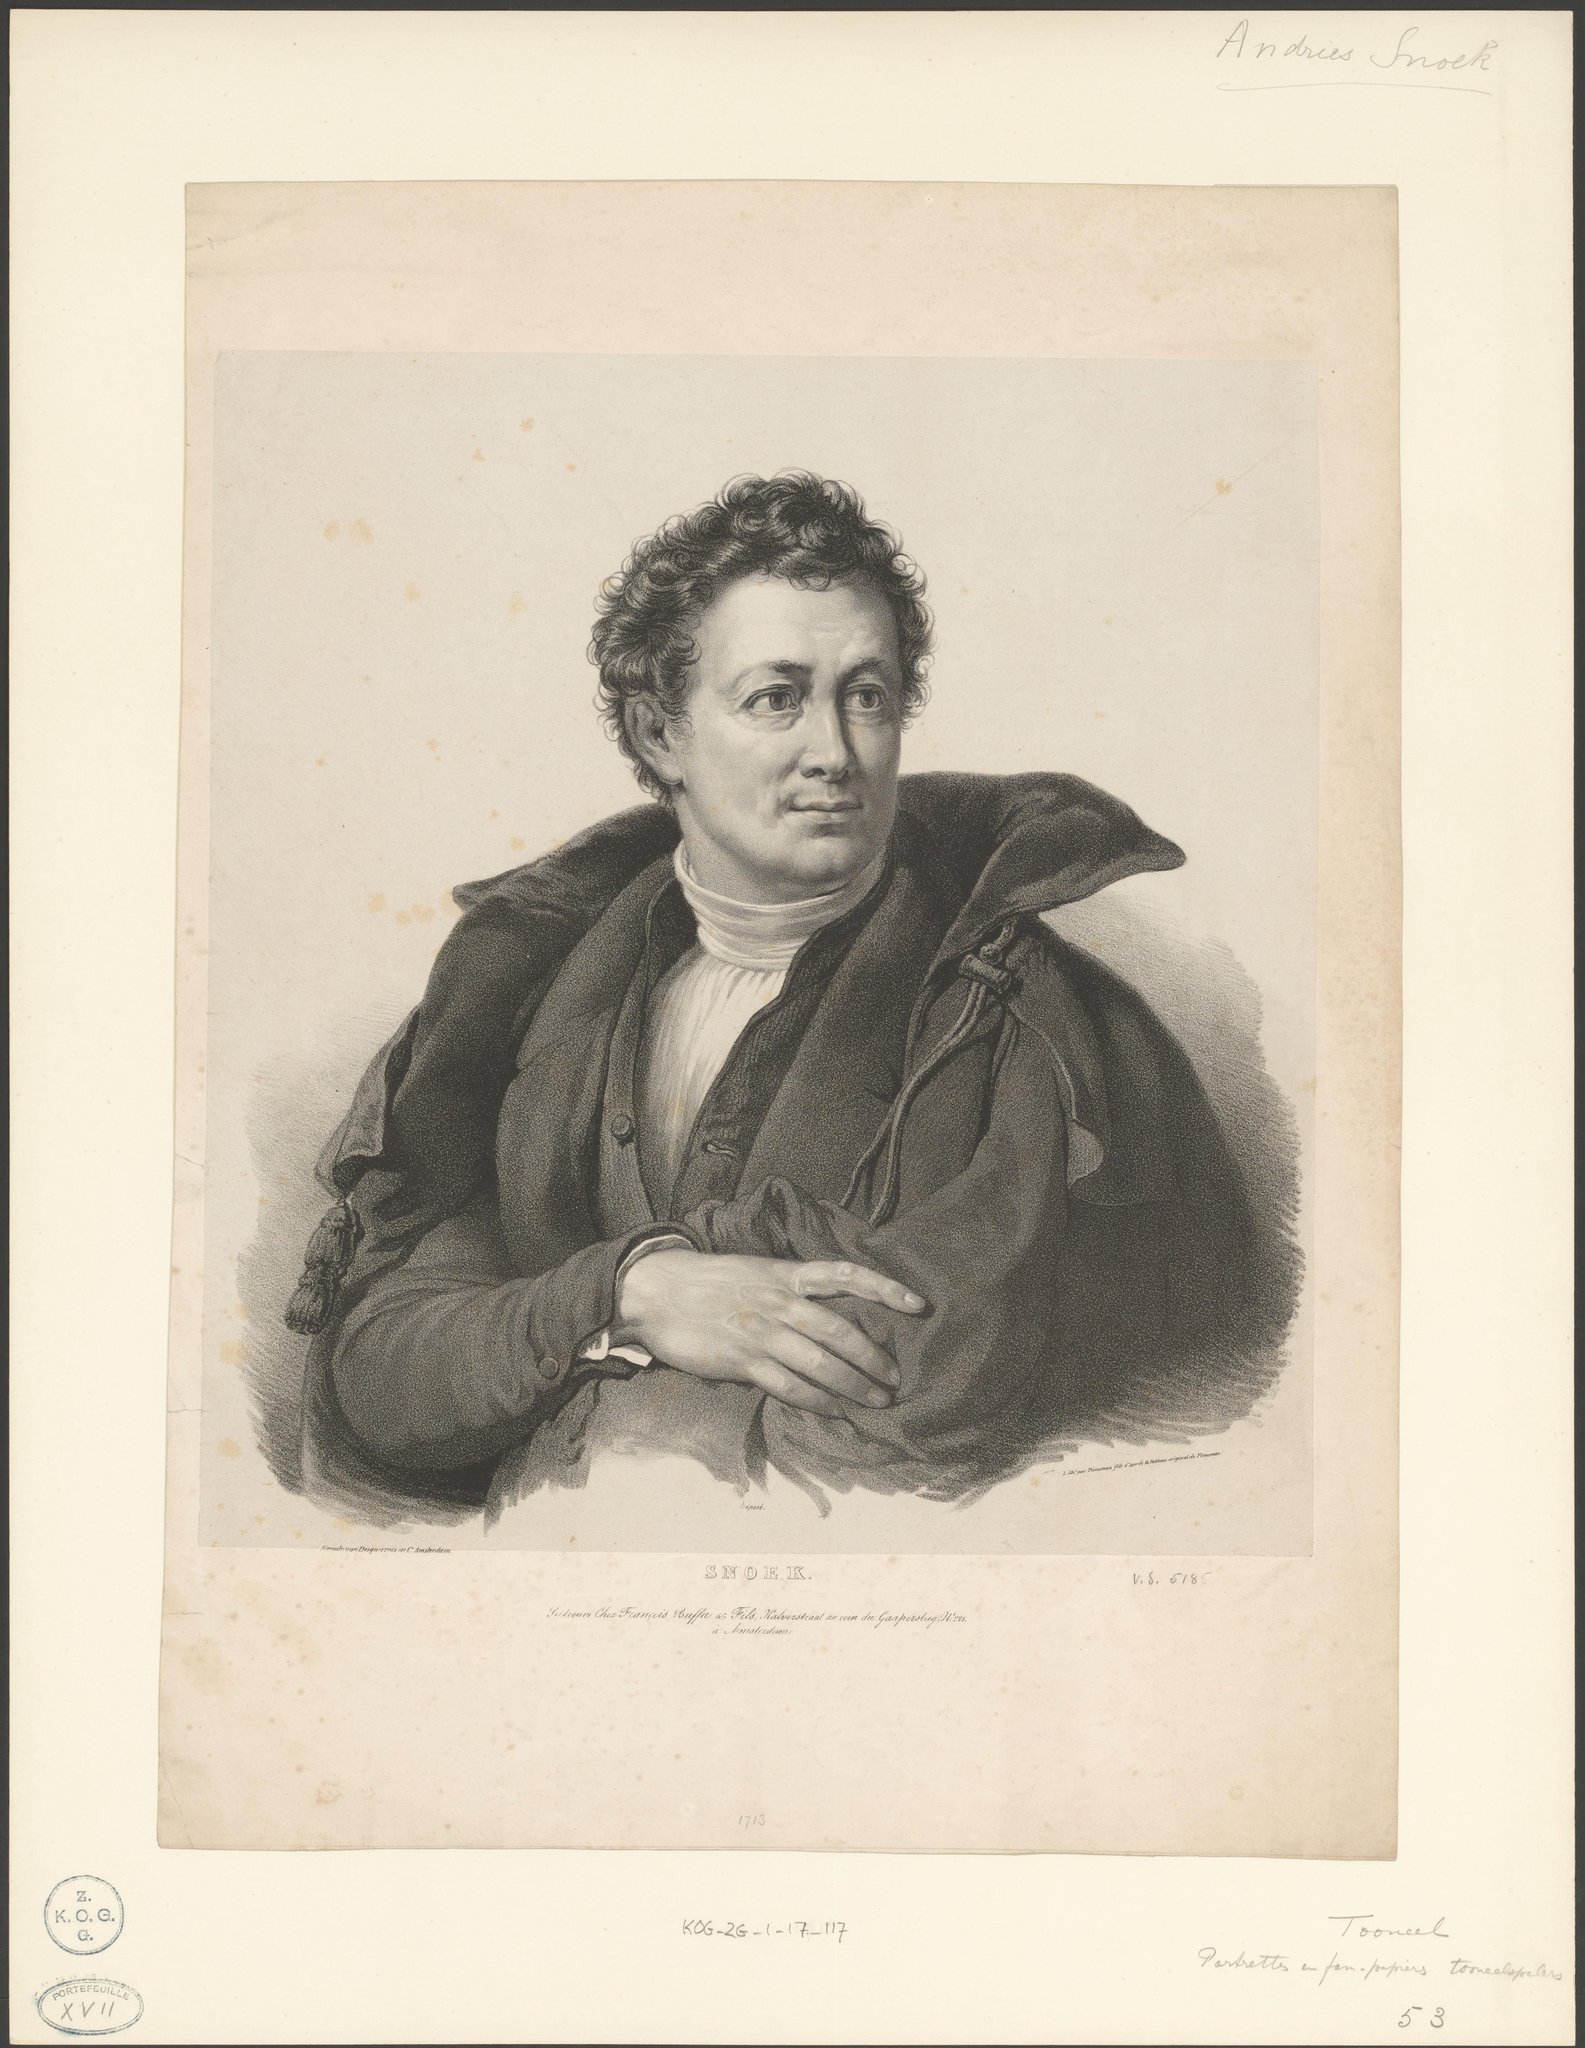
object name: print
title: Snoek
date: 1829-1860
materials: paper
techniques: lithograph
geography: amsterdam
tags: rotterdam, amsterdam, historical persons, portrait of actor, actress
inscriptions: stamp, : ‘Déposé’, collector's mark: Lugt 1641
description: Onderwerpsrubrieken binnen de Atlas Zeden en Gewoonten: Tooneel, Portretten van toneelspelers.